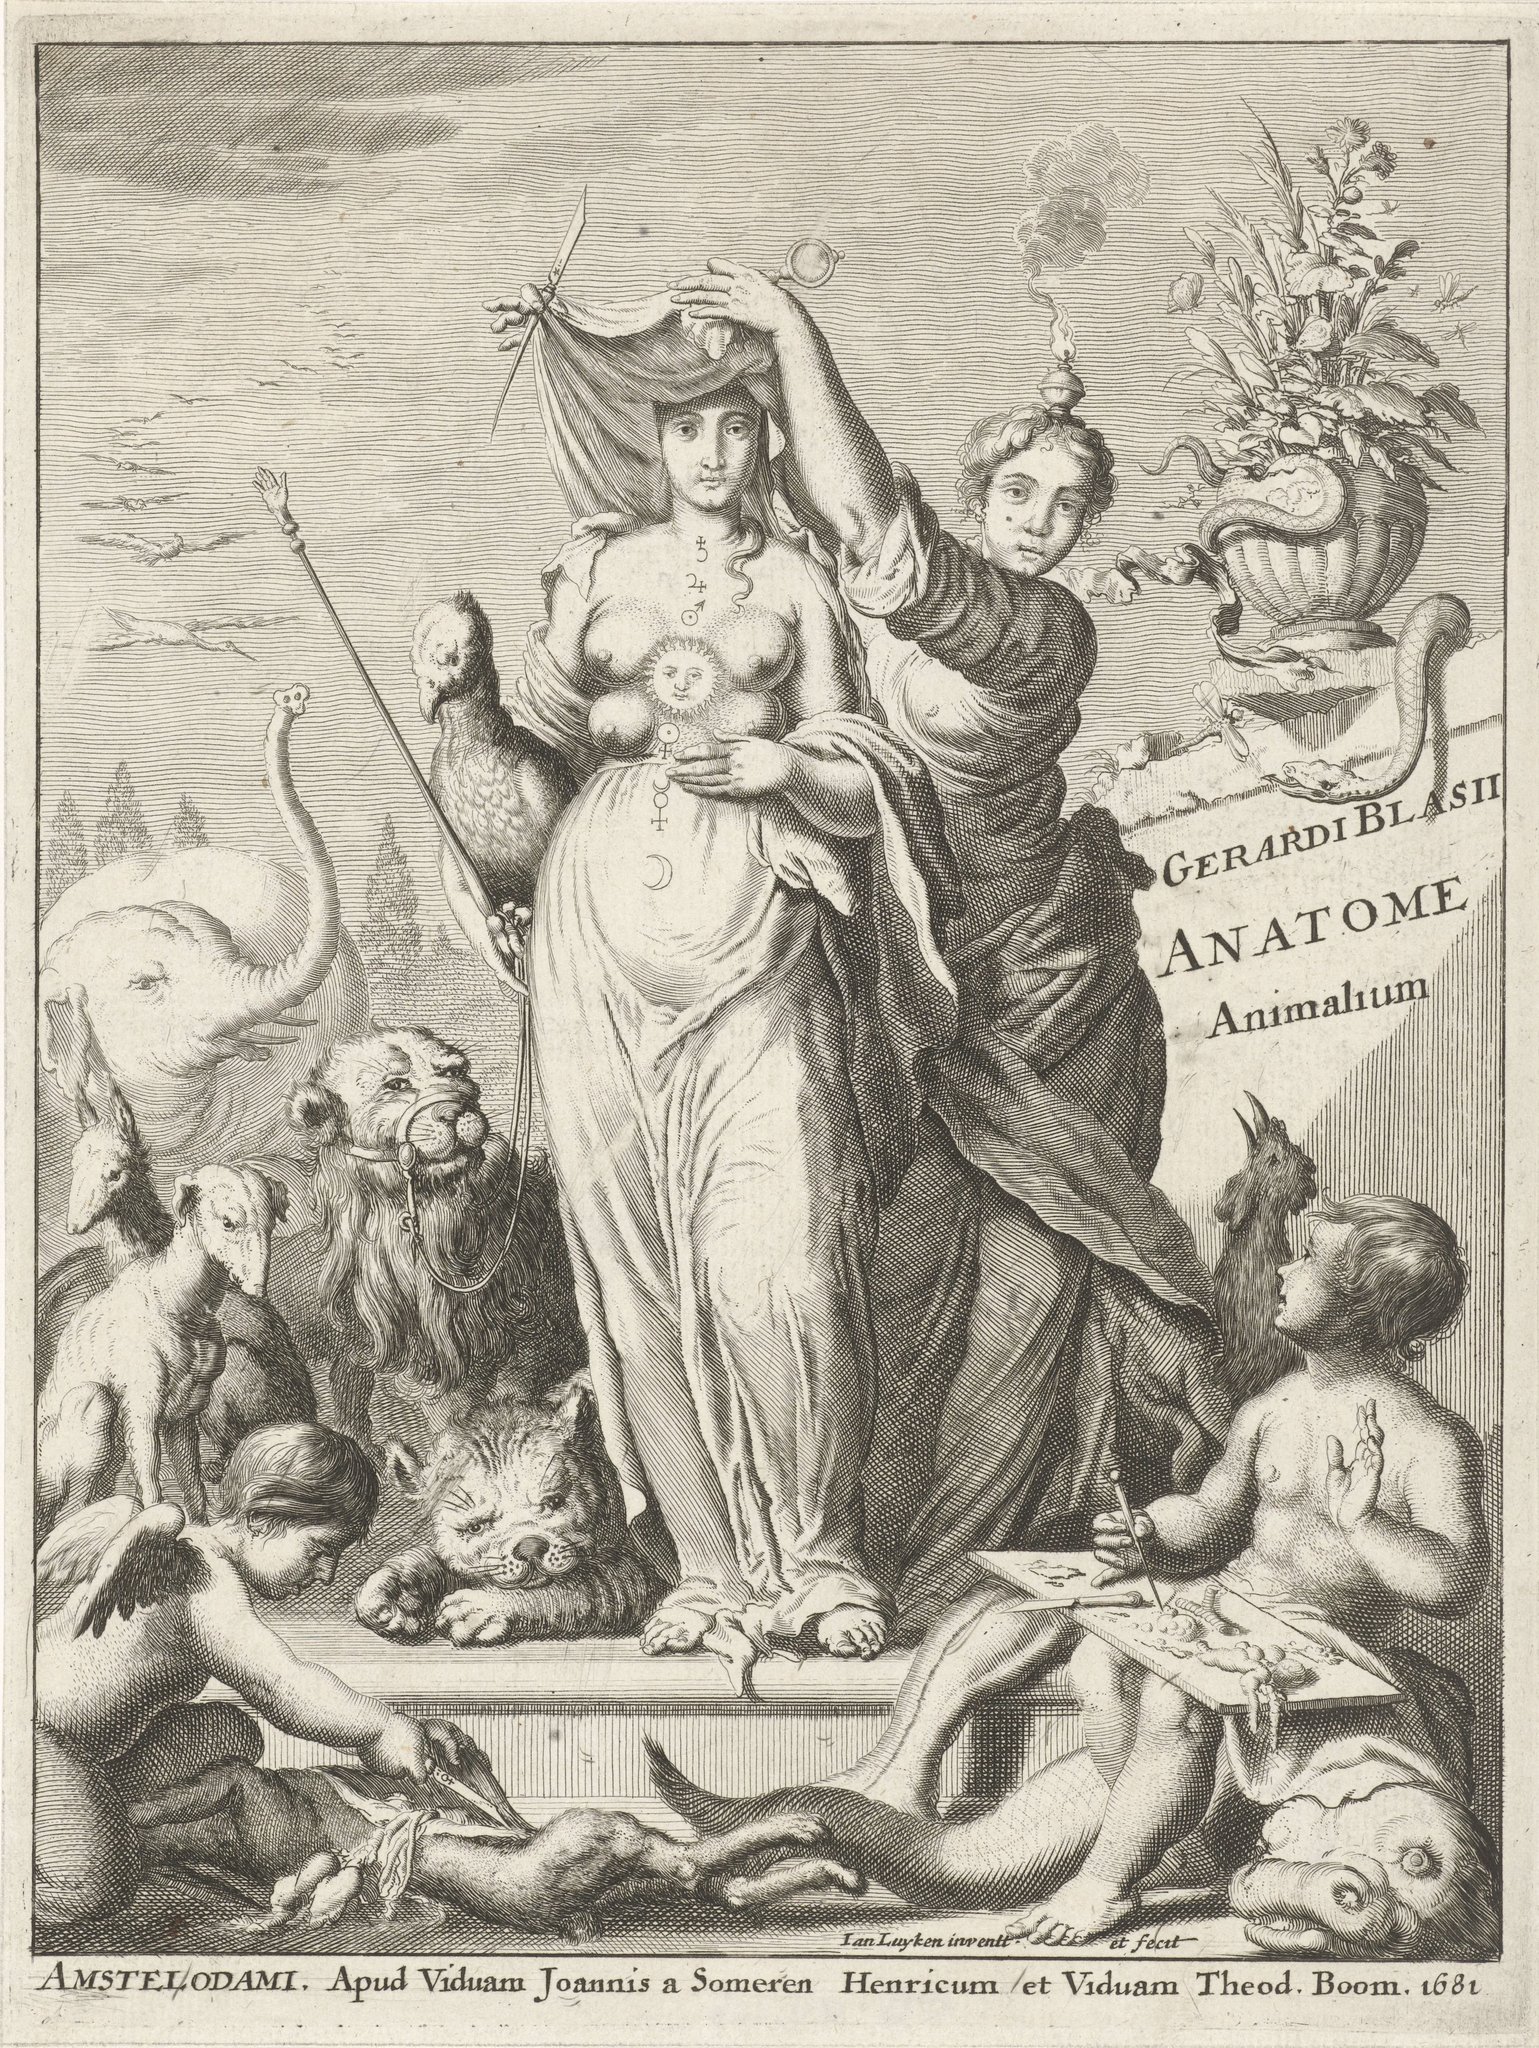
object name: print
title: Natura omringd door dieren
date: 1681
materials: paper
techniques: etching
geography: amsterdam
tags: 'natura' (allegorical figure or scene; or as diana of ephesus, with many breasts); 'natura' (ripa) (+ variant), cupids: 'amores', 'amoretti', 'putti'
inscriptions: collector's mark: Lugt 2228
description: Natura, omringd door een aantal dieren, wordt ontsluierd door een allegorische vrouwenfiguur. Op de voorgrond ontleden twee engelen zeedieren en een haas.